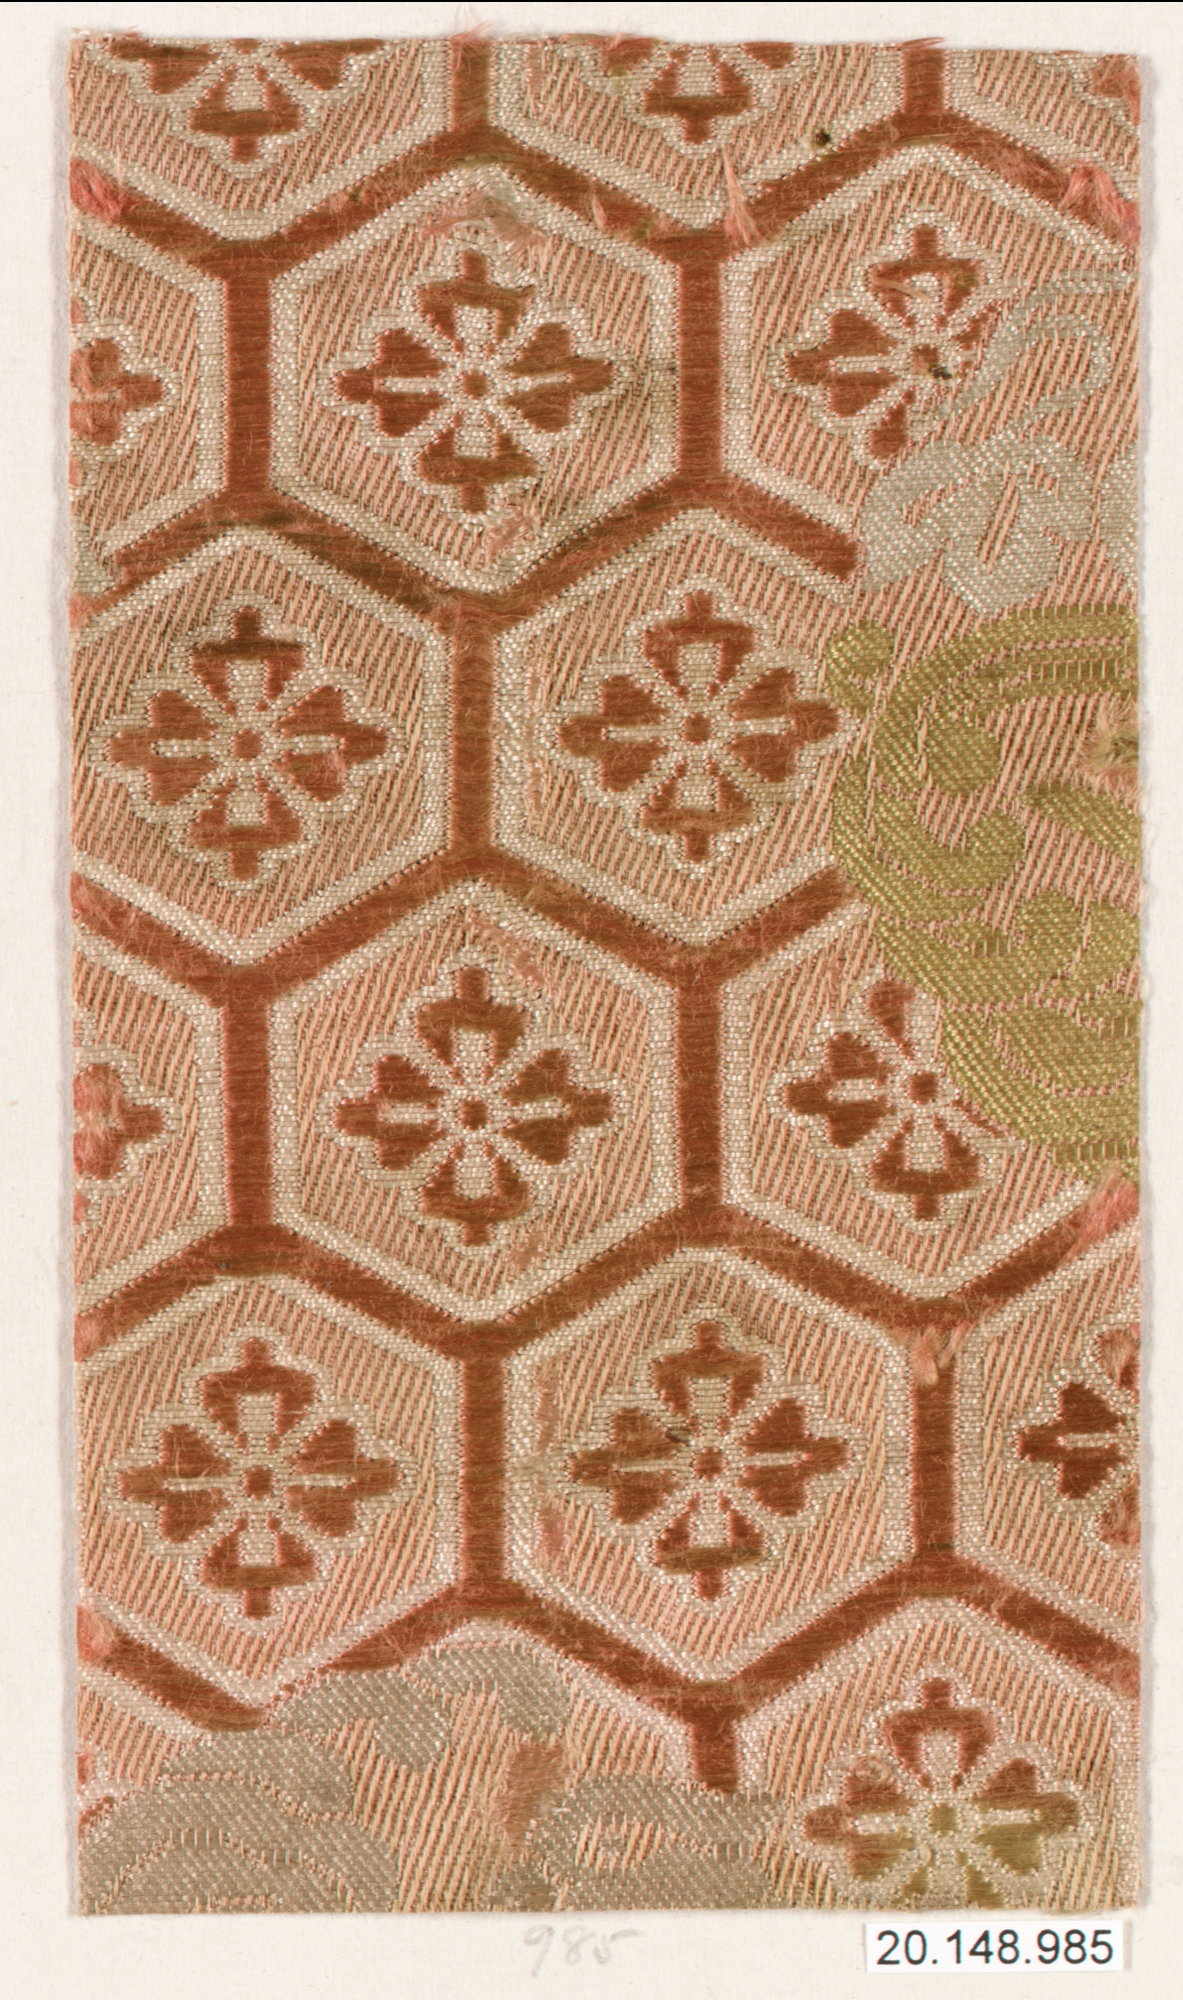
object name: piece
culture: japanese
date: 1701-1800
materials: silk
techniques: compound weave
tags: flowers